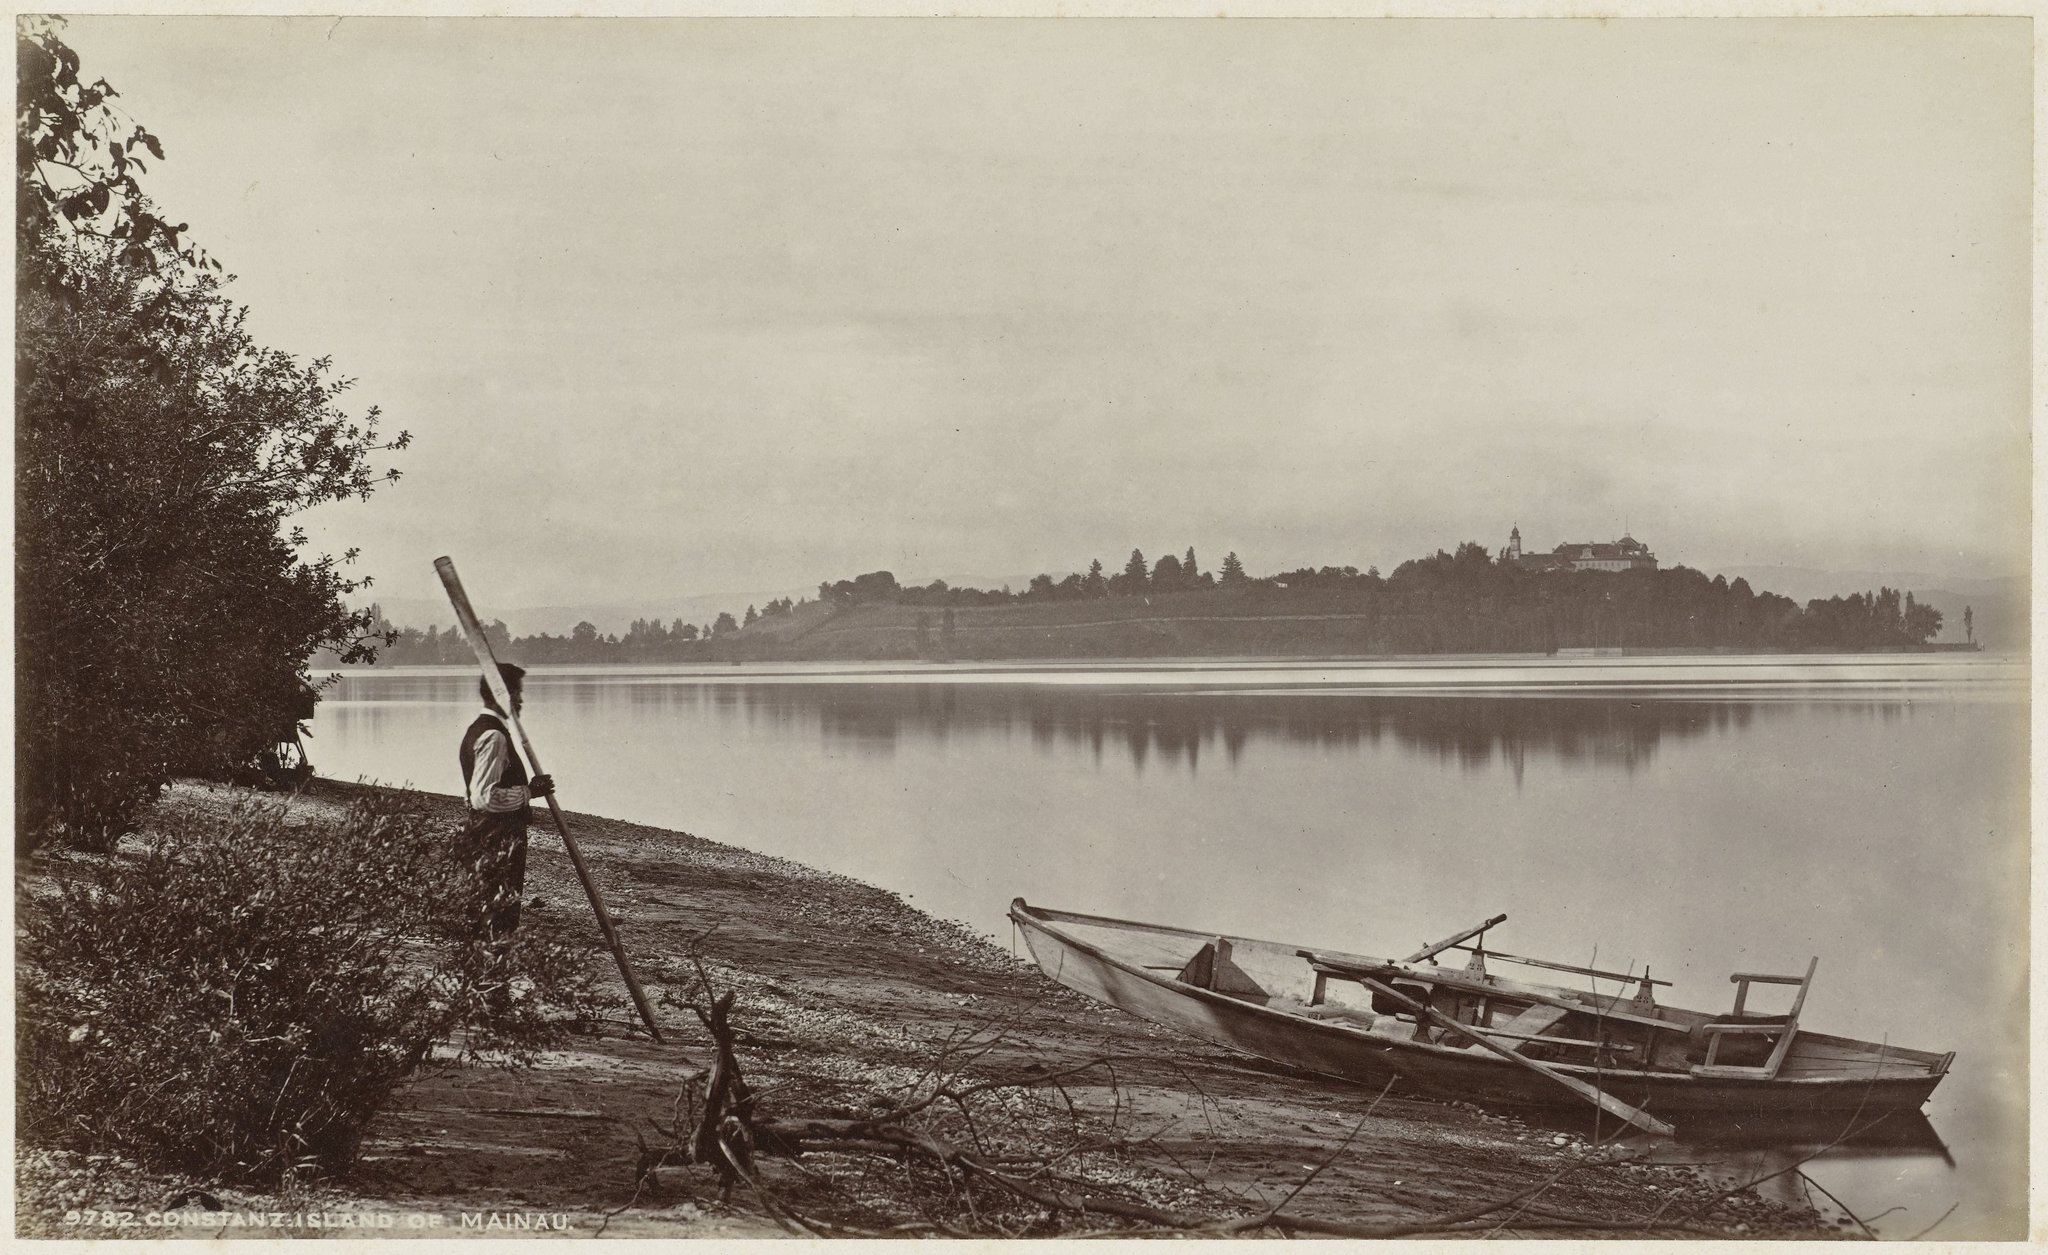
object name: photograph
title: Constanz: Island of Mainau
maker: Anonymous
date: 1859-1890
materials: cardboard, paper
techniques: albumen print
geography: great britain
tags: island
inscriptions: date: ‘maandag 6 juli’, number: ‘28’